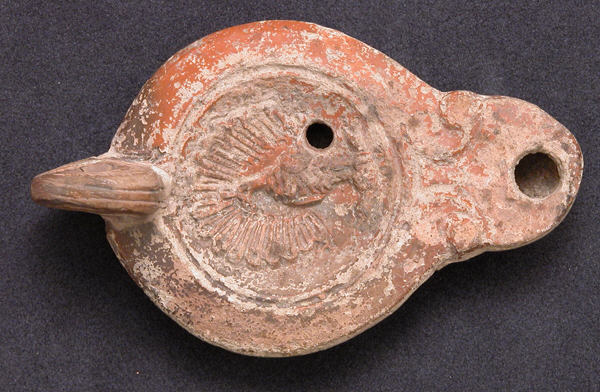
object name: lamp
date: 101-200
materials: earthenware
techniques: molding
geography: egypt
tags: peacocks